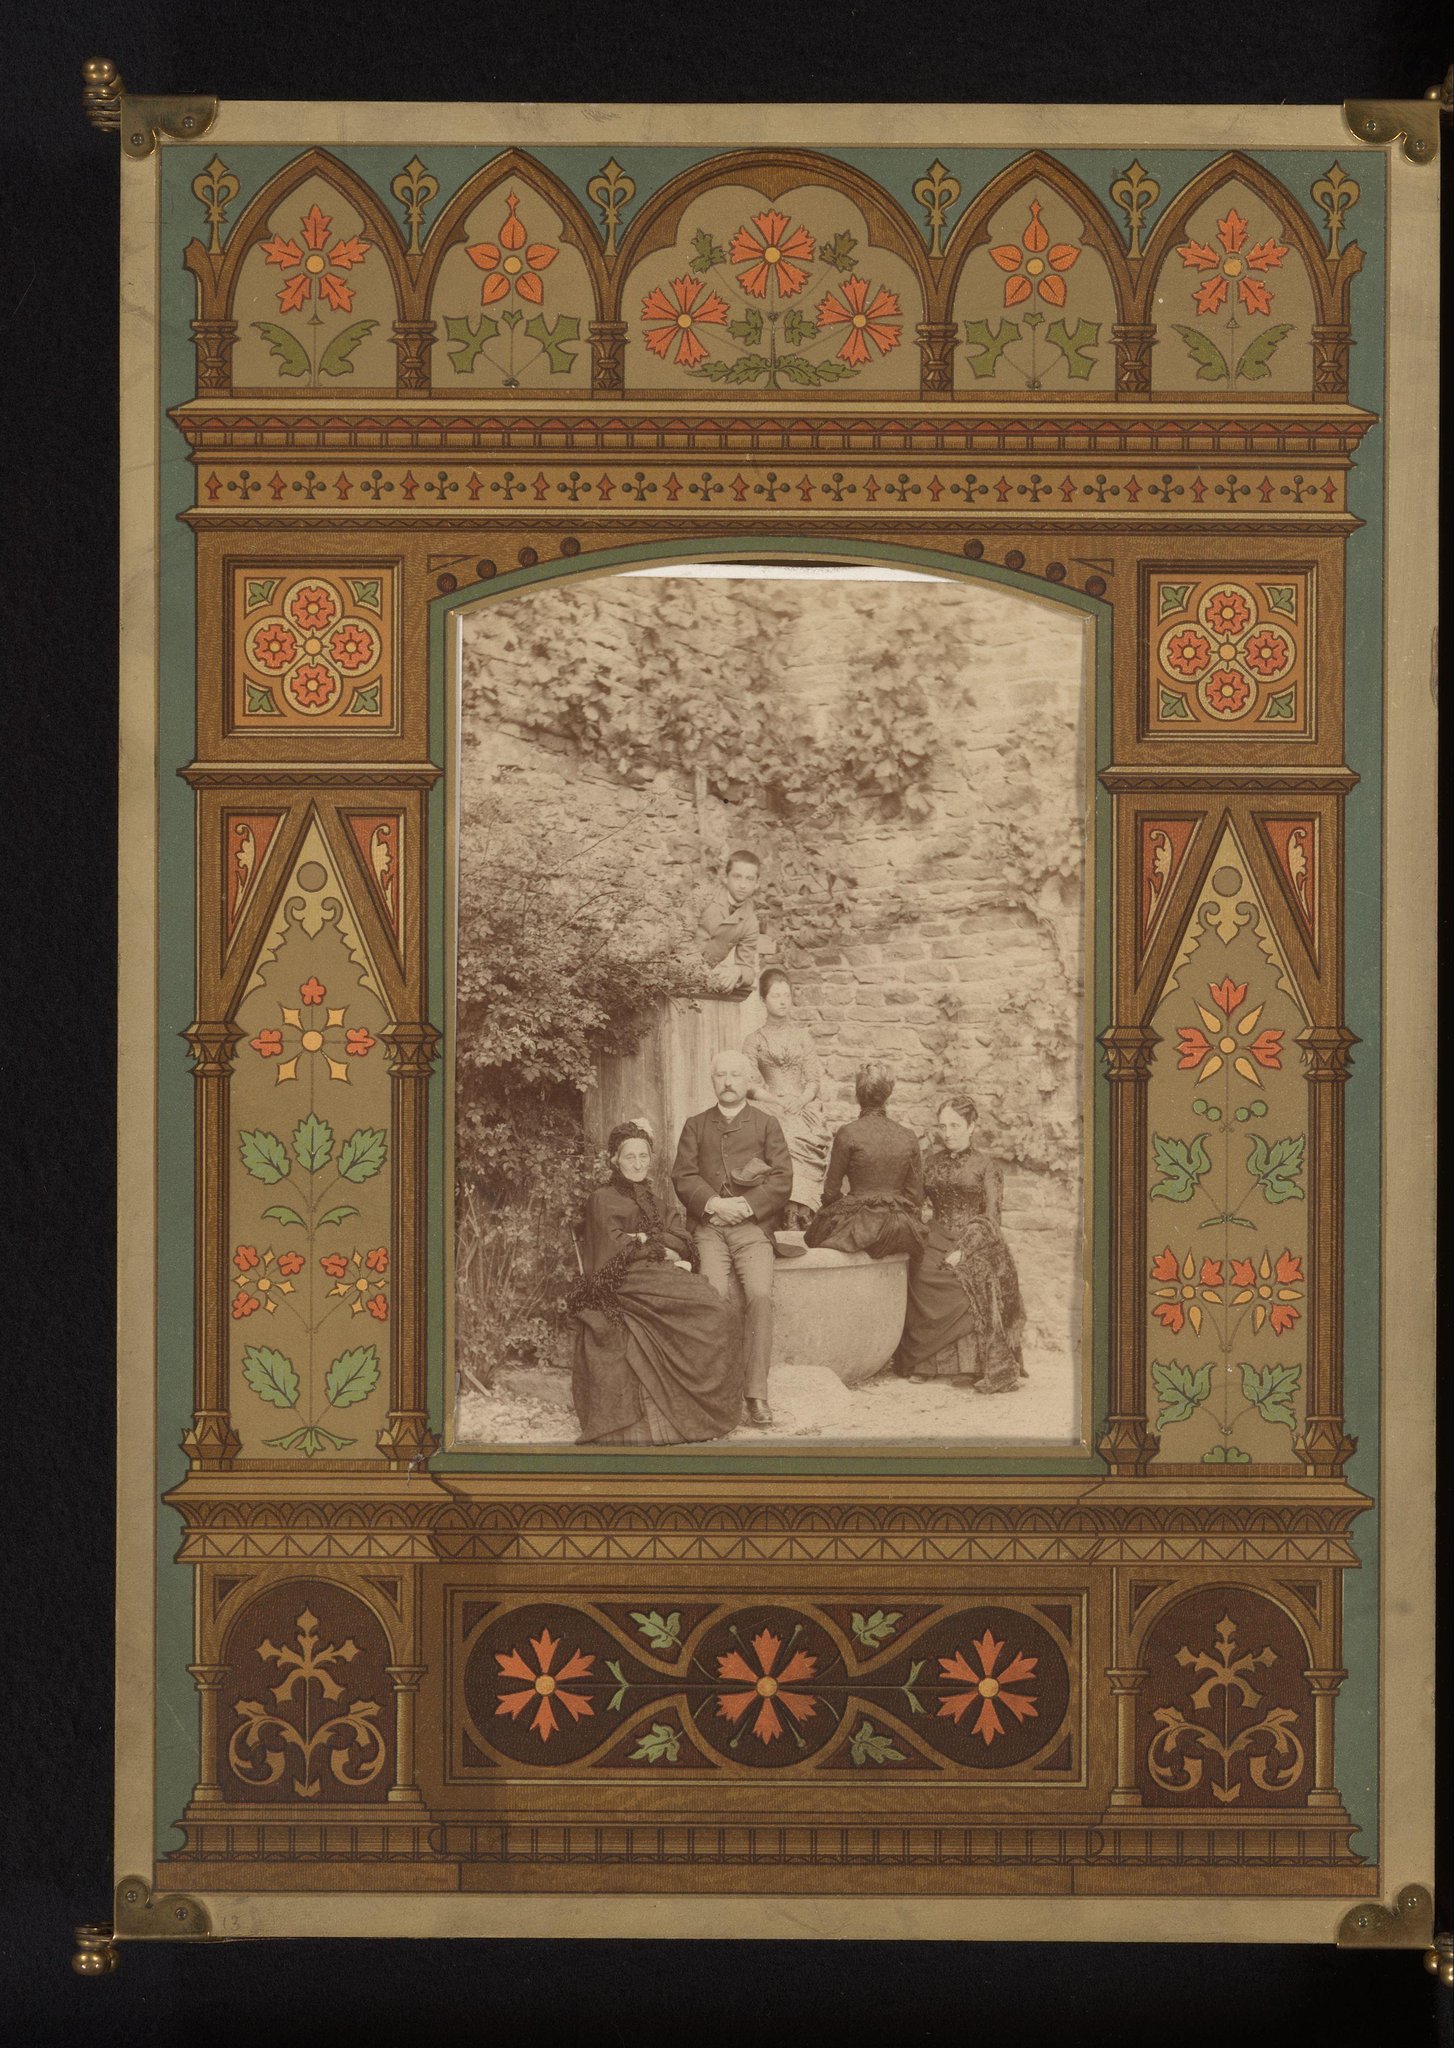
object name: album leaf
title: Groepsportret van twee mannen en vier vrouwen, waarvan één op de rug gezien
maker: Anonymous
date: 1850-1900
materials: cardboard, photographic support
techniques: albumen print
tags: adult man (+ two persons), adult woman (+ four persons), anonymous historical persons portrayed in a group, in a group-portrait